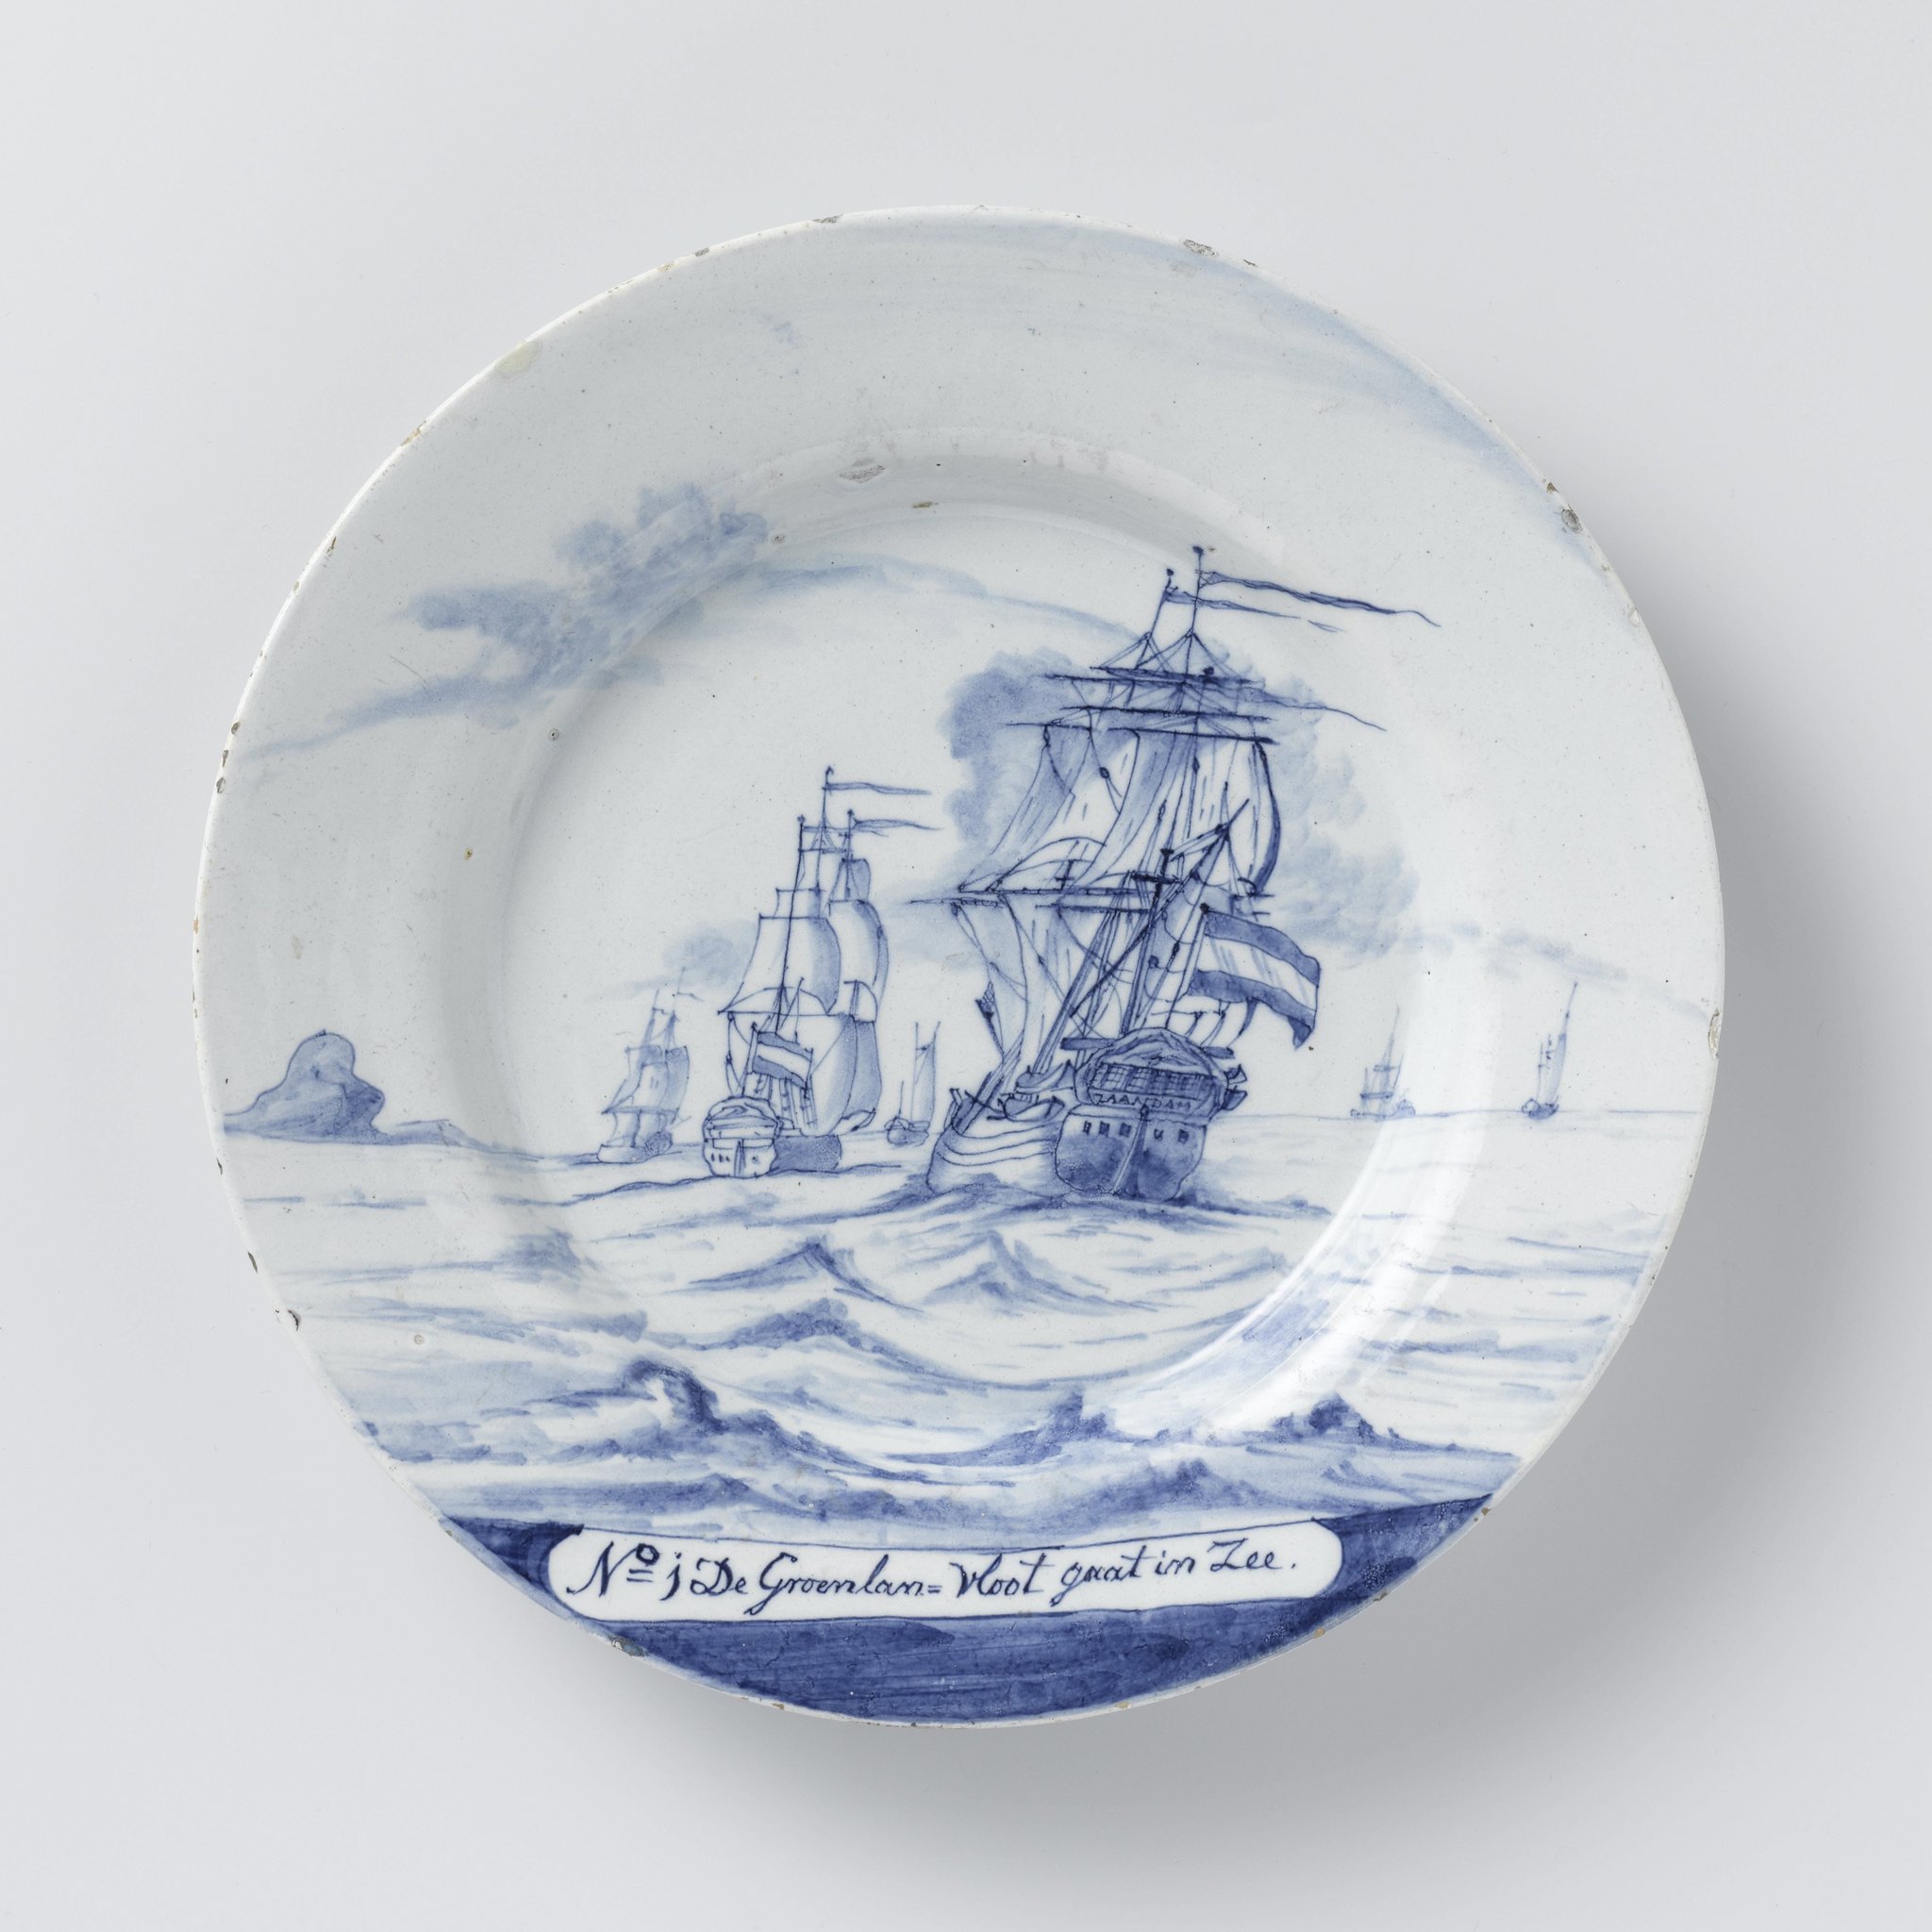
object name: plate dish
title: Bord met zes schepen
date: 1750-1780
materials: faience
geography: delft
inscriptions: mark: ‘figuratief teken bijltje met L’, inscription: ‘No 1 De Groenlan Vloot gaat in Zee’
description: Bord van faience. Blauw beschilderd met zes schepen. Bord uit een serie: De Groenlandvaart.